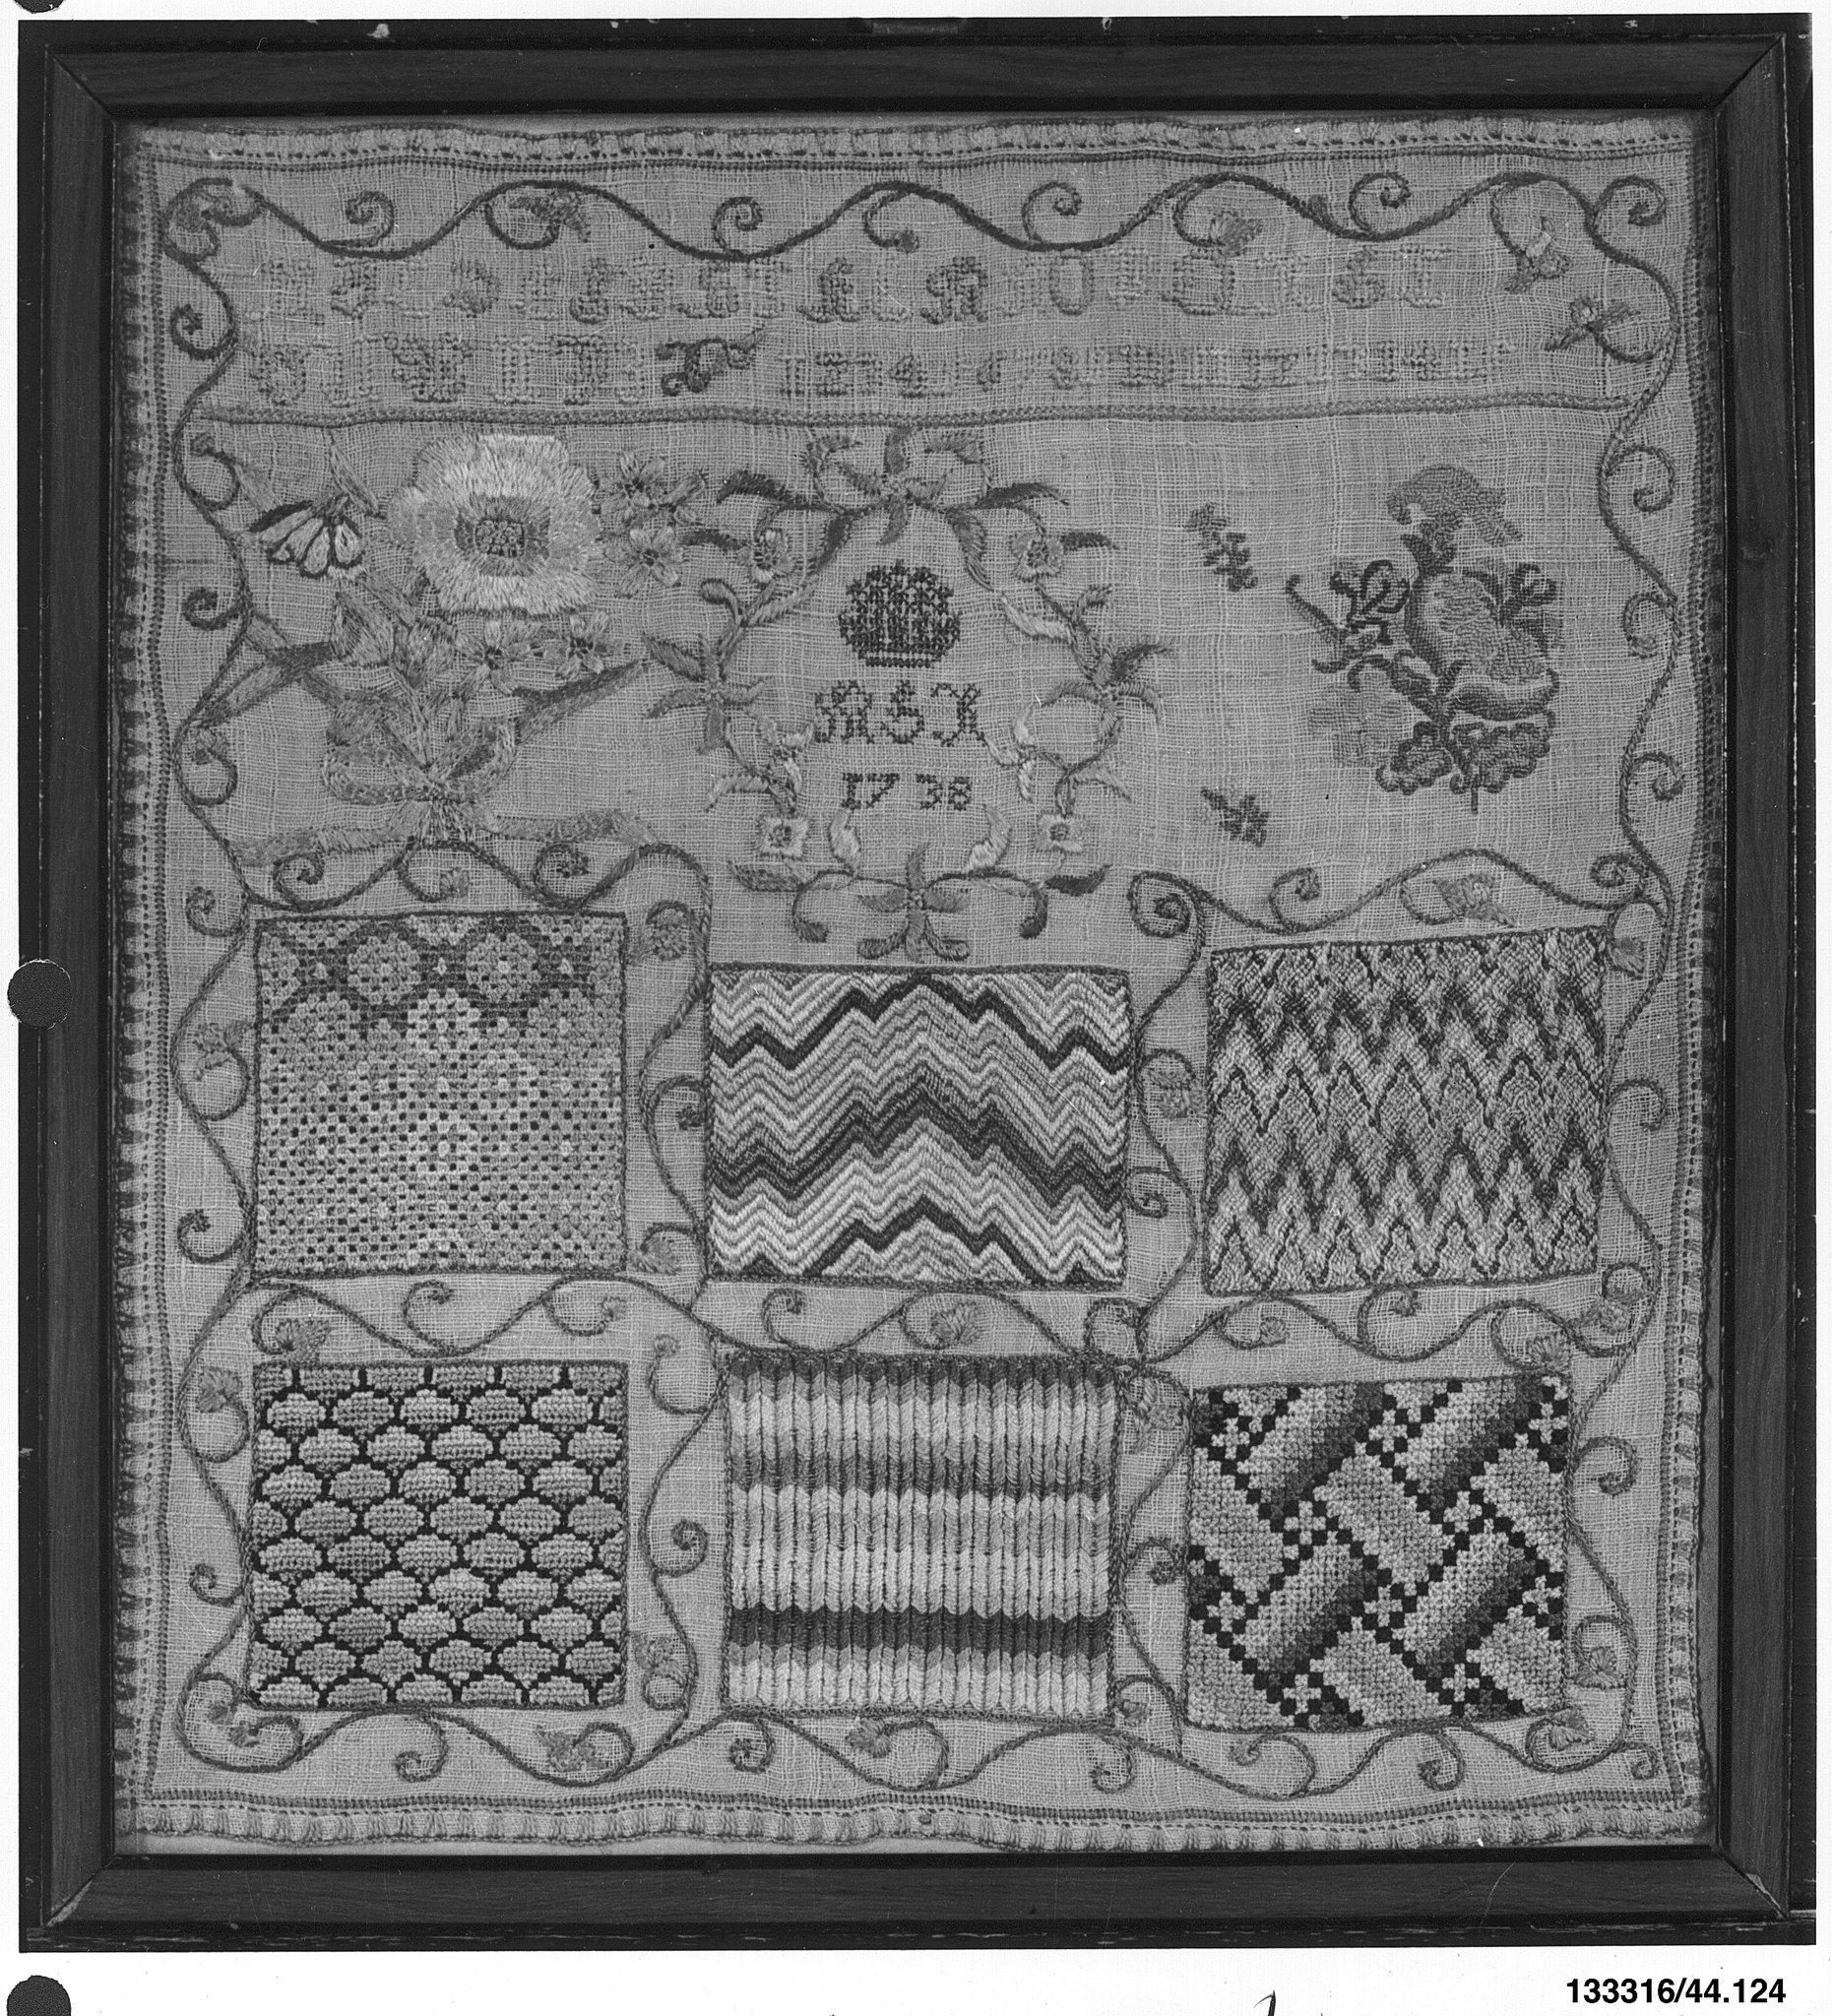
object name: sampler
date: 1738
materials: linen, silk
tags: birds,flowers